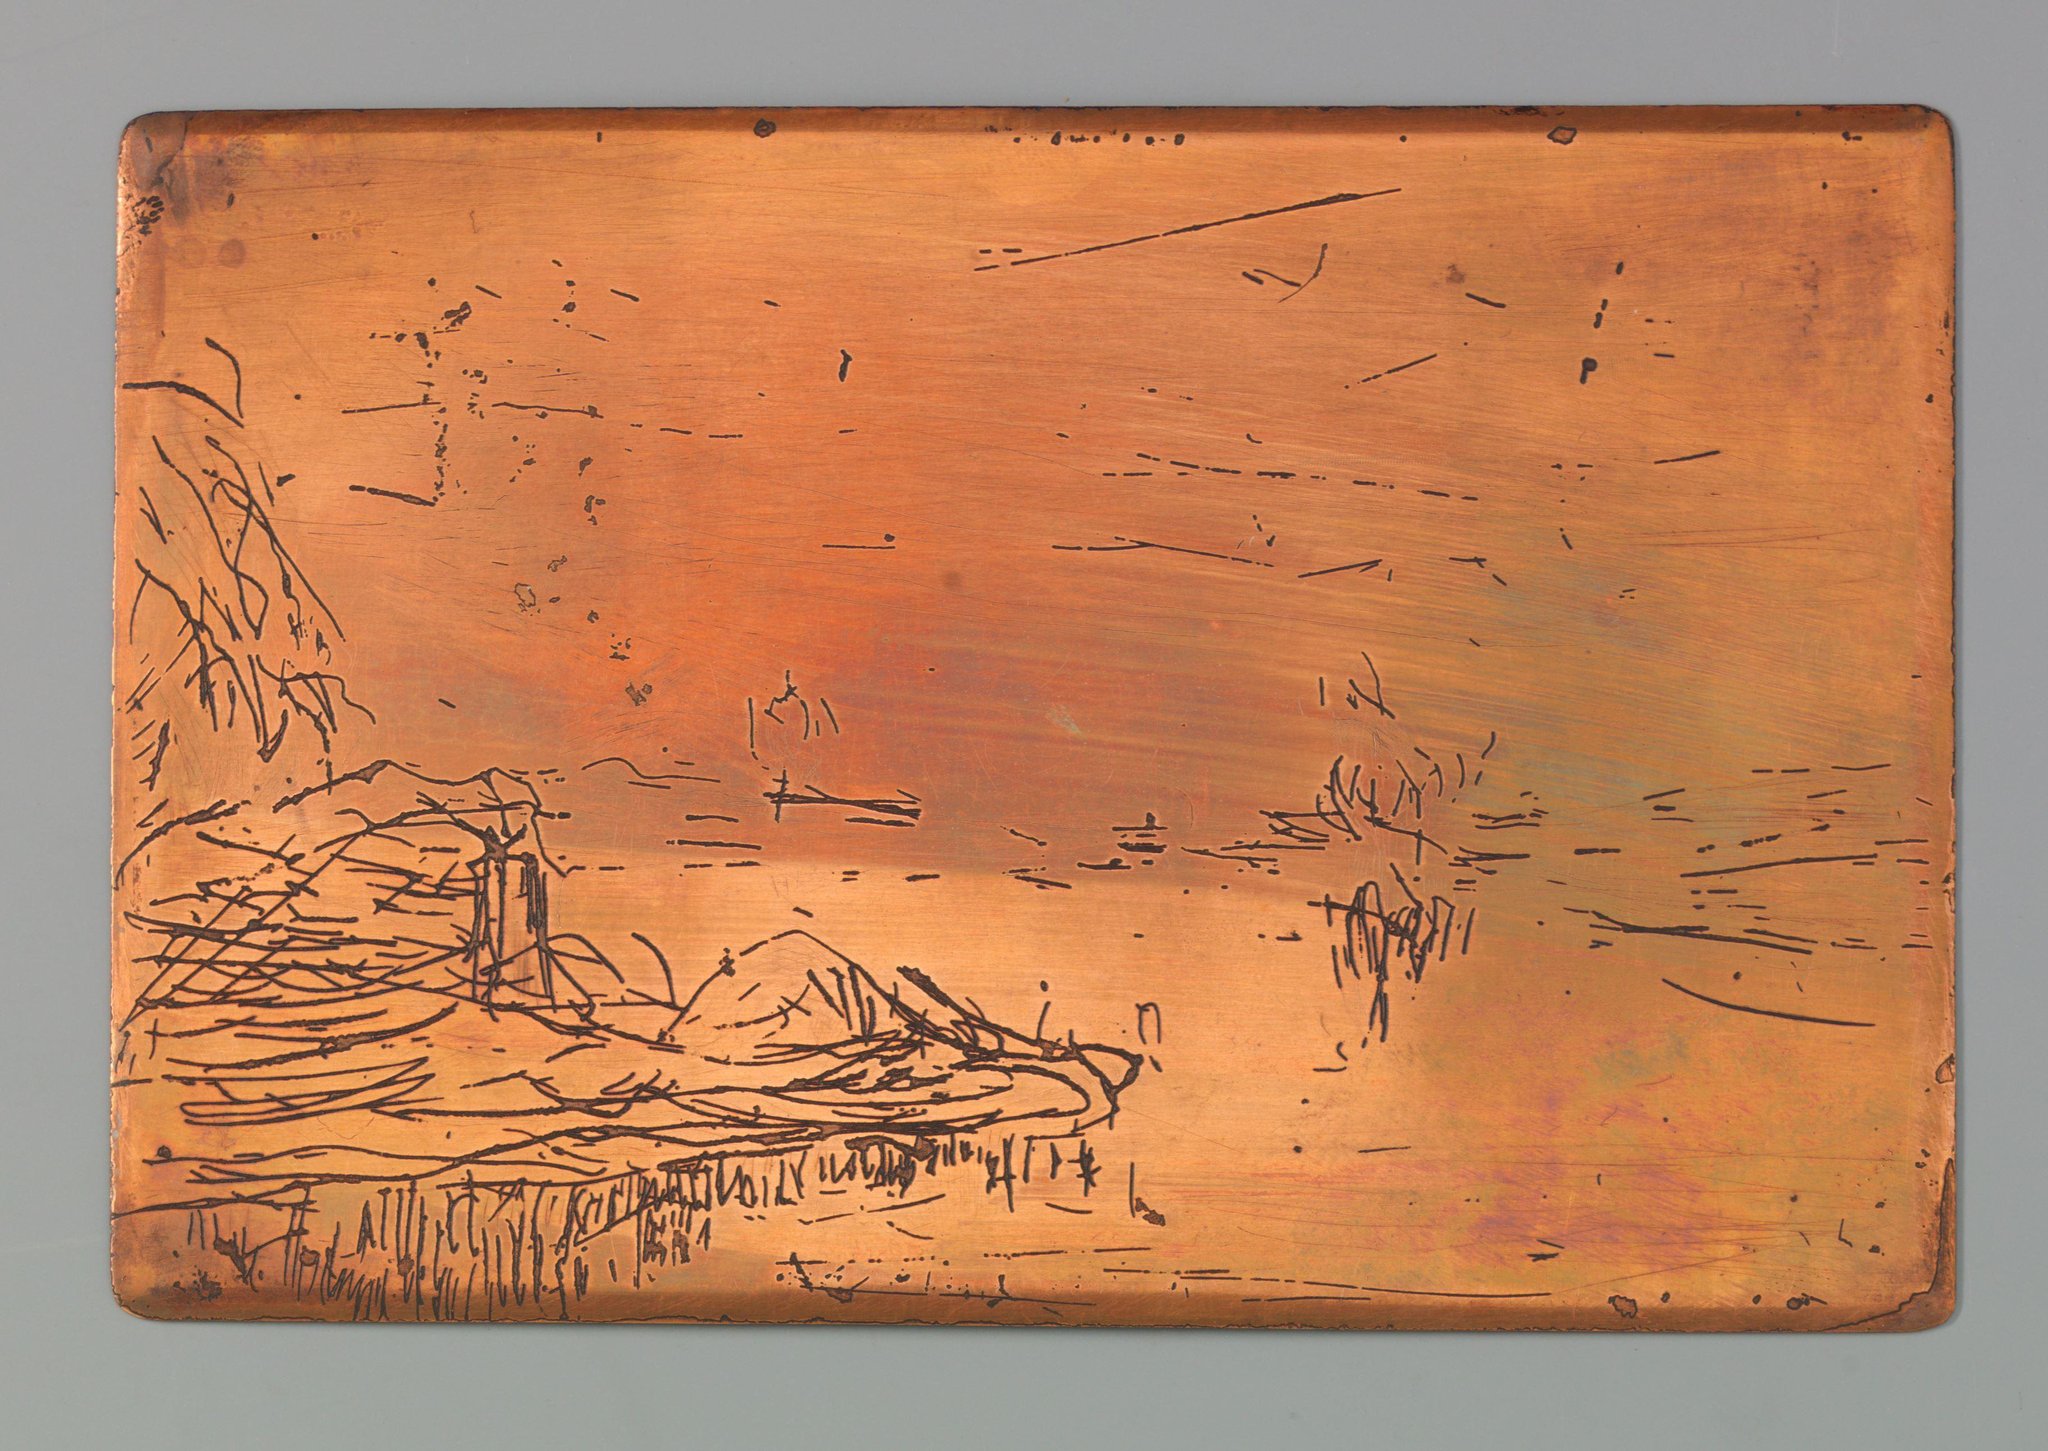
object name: copper plate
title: Mestvaalten bij avond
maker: floris verster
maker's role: draughtsman, painter, print maker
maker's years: 1861-1927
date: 1890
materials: copper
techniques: etching